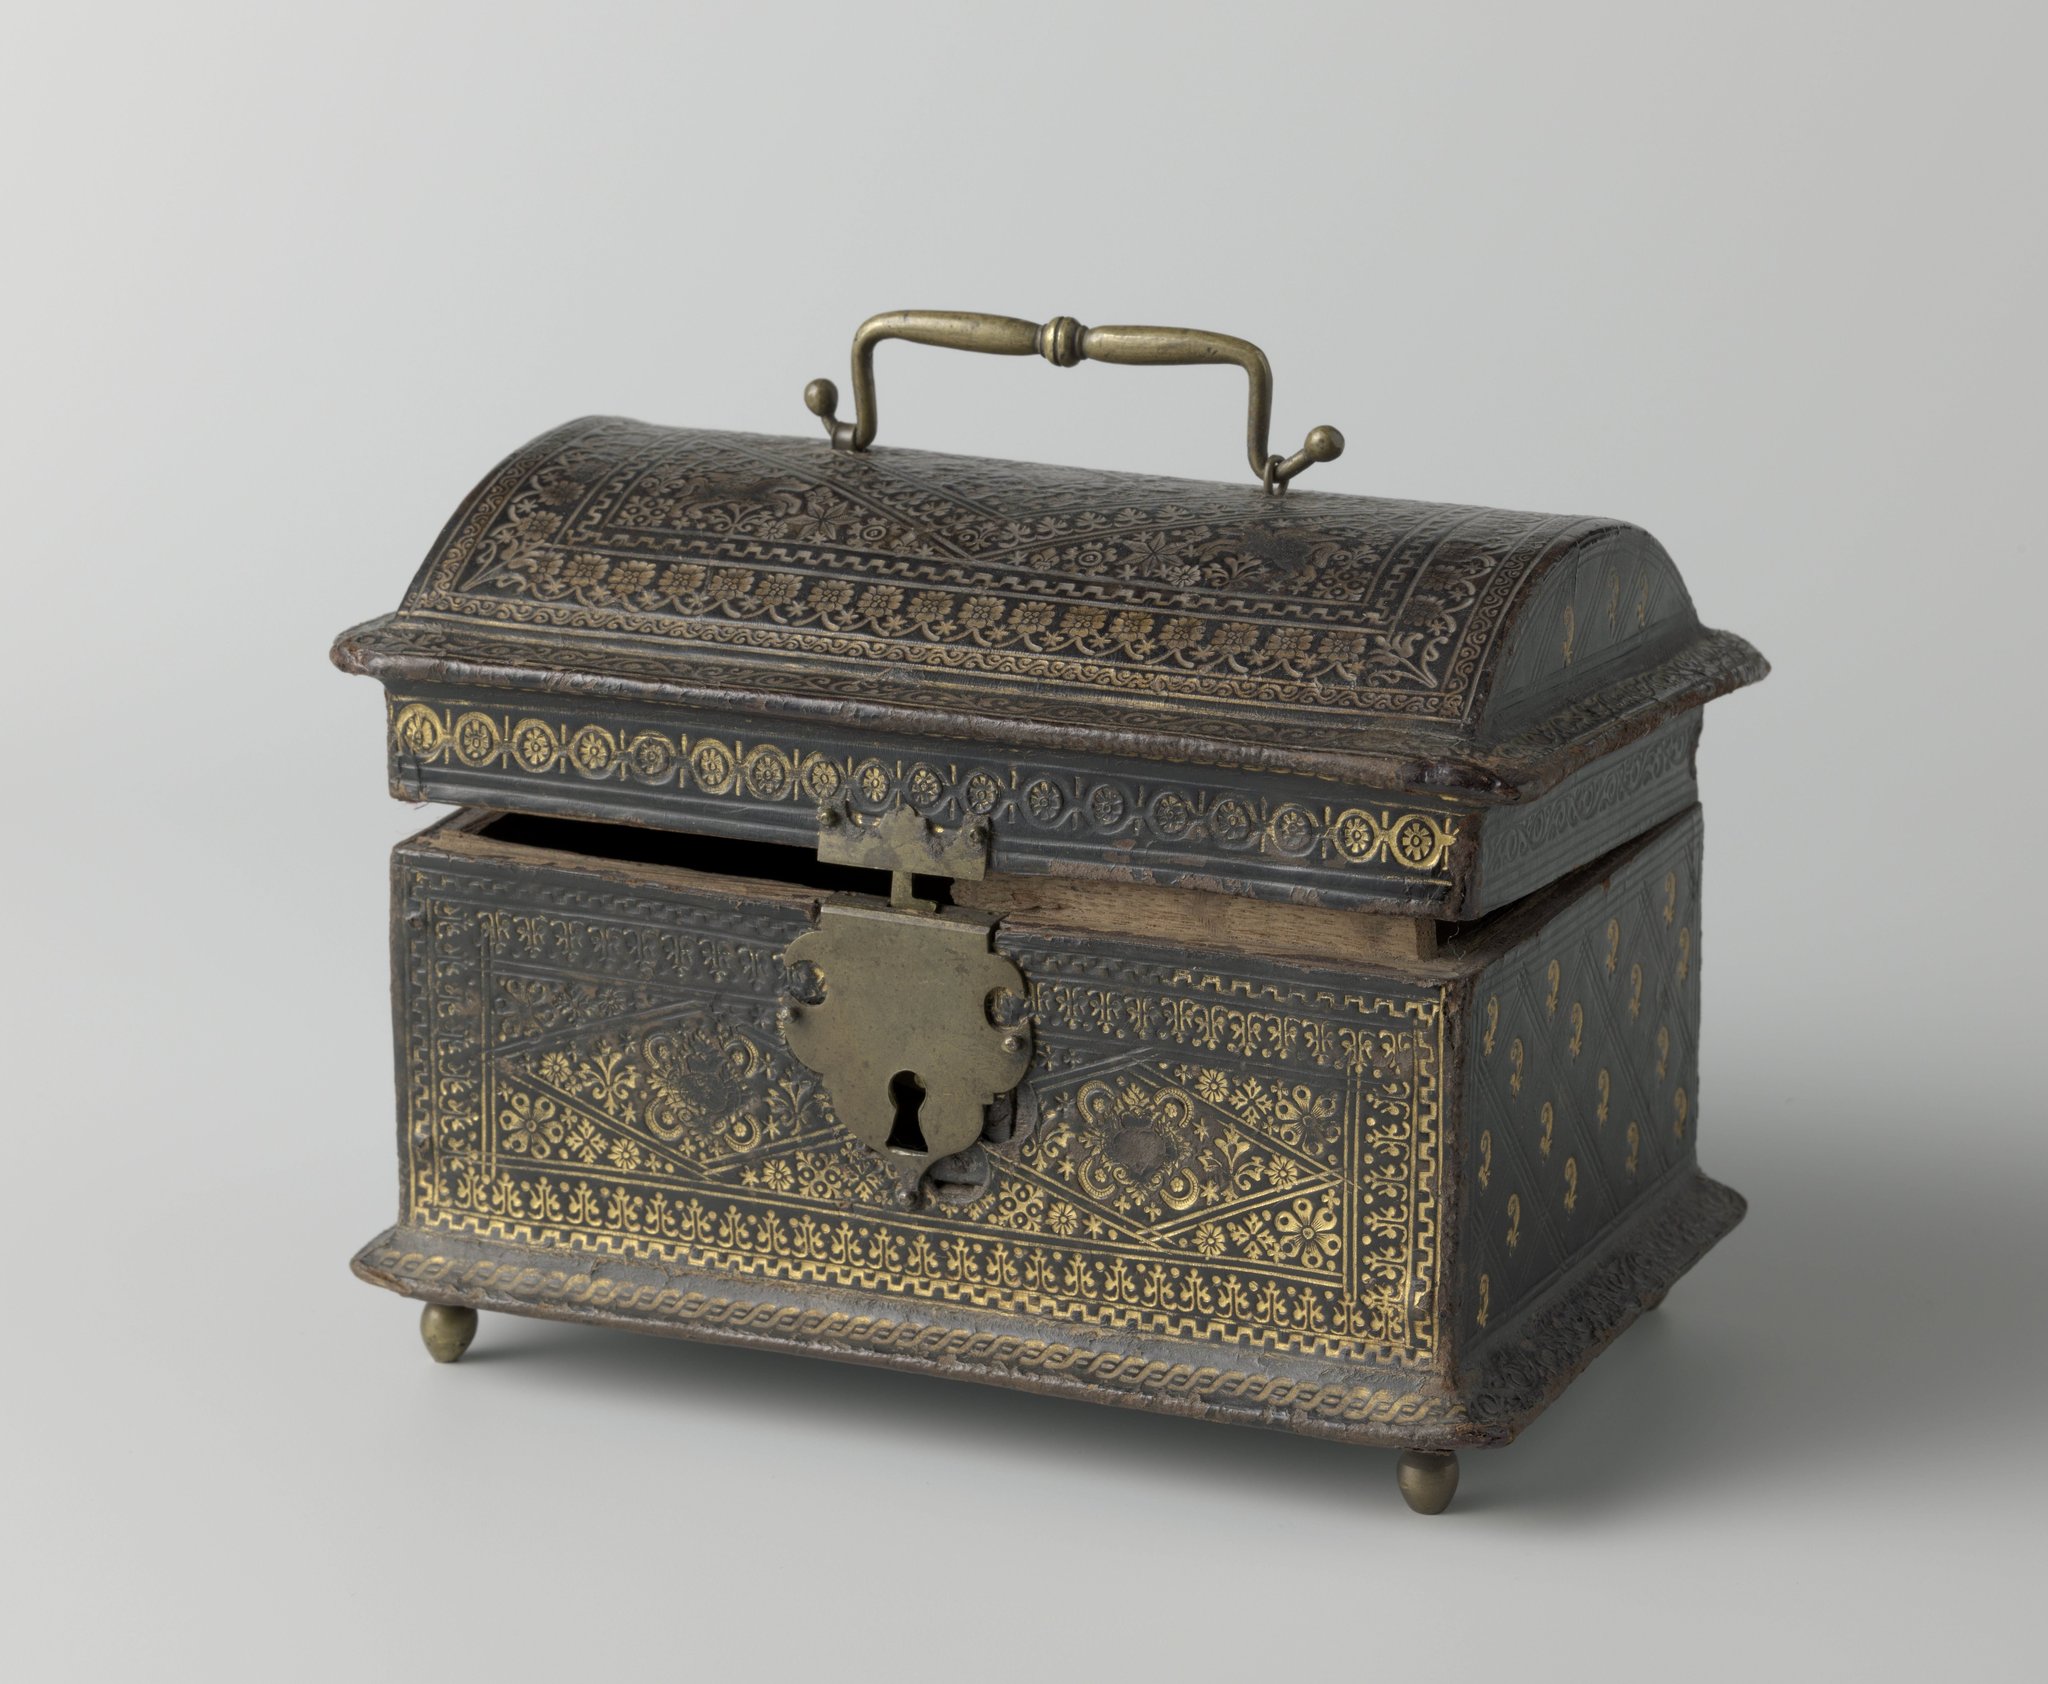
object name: chest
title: Kist bekleed met bestempeld leer waarvan met vergulde ornamenten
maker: Anonymous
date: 1604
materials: brass, gold, leather, wood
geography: northern netherlands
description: Kist van eikenhout bekleed met gestempeld leer waarvan de ornamenten verguld zijn. De voorzijde vertoont binnen ruiten inééngeslagen handen. Op het gebolde deksel dit zelfde motief met ter weerszijden dolfijnen eveneens binnen ruiten. In de zwikken gevleugelde paardjes. Op achter en zijkanten een ruitindeling waarbinnen gestileerd bladmotief. Onder op het kist eveneens een ruitdeling met daarin ANNO 1604 en de letters K.V.P. Het kist rust op vier koperen voeten en heeft een koperen slotplaat met sleutel en op het deksel een koperen hengsel. Inwendig vertoont het kist nog enkele resten.